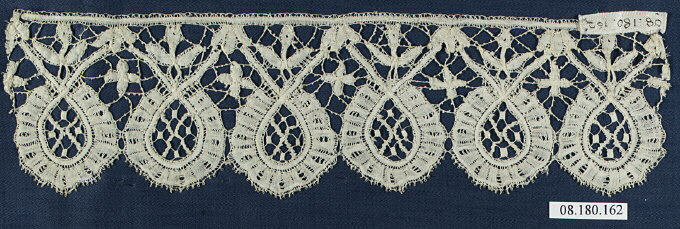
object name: fragment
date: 1801-1833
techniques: lace